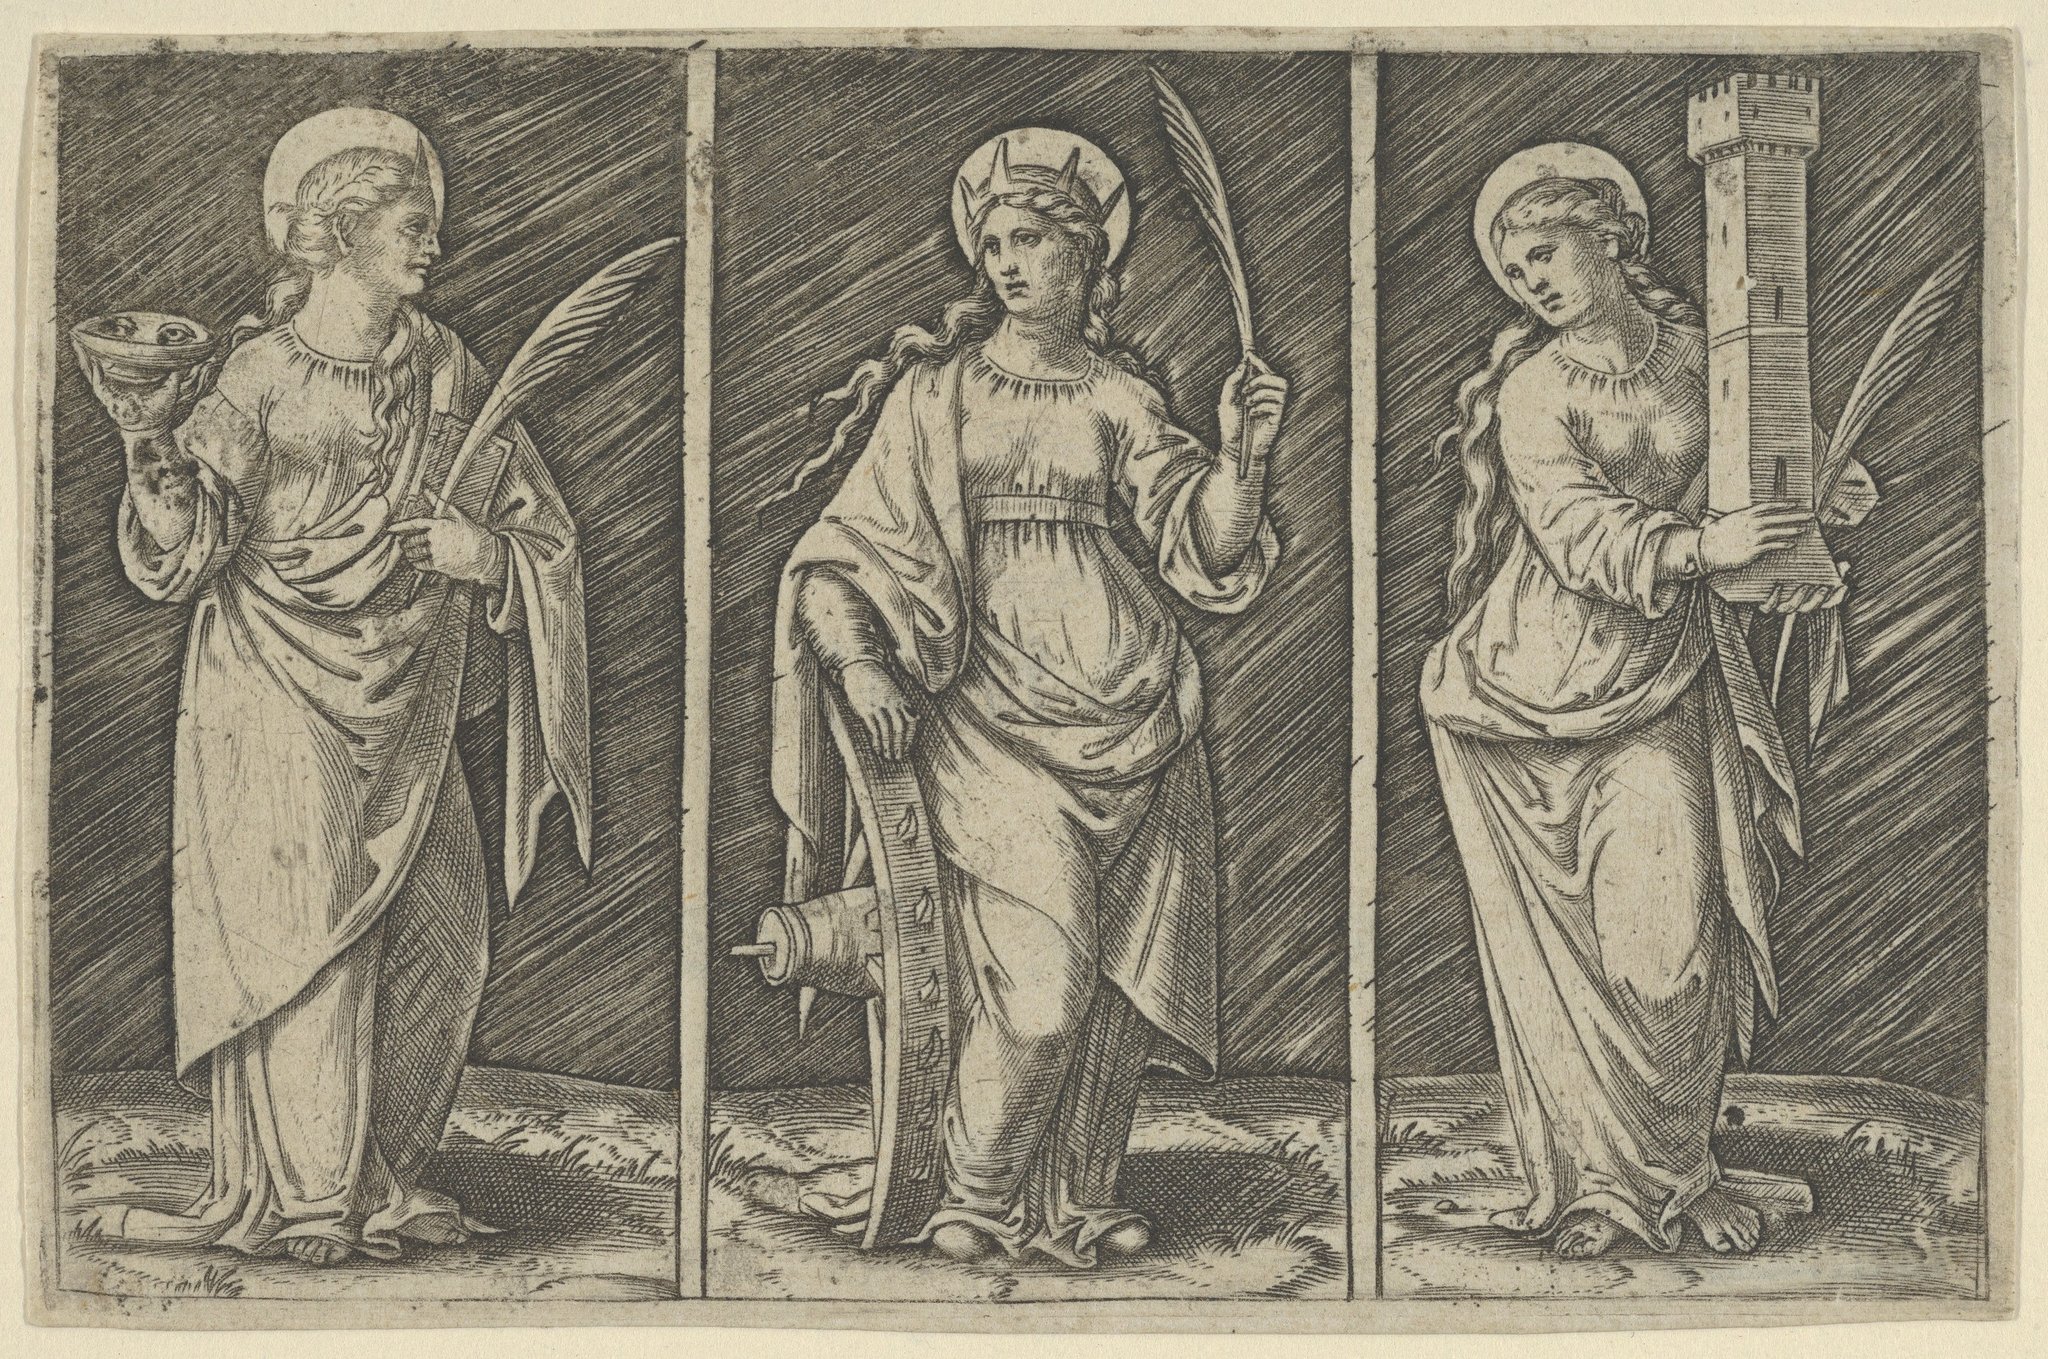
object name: print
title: Saint Barbara (left), Saint Catherine, (center), Saint Lucy (right)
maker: marcantonio raimondi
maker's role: artist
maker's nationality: italian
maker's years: 1475-1534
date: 1500-1527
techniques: engraving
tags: women,saint catherine,saints